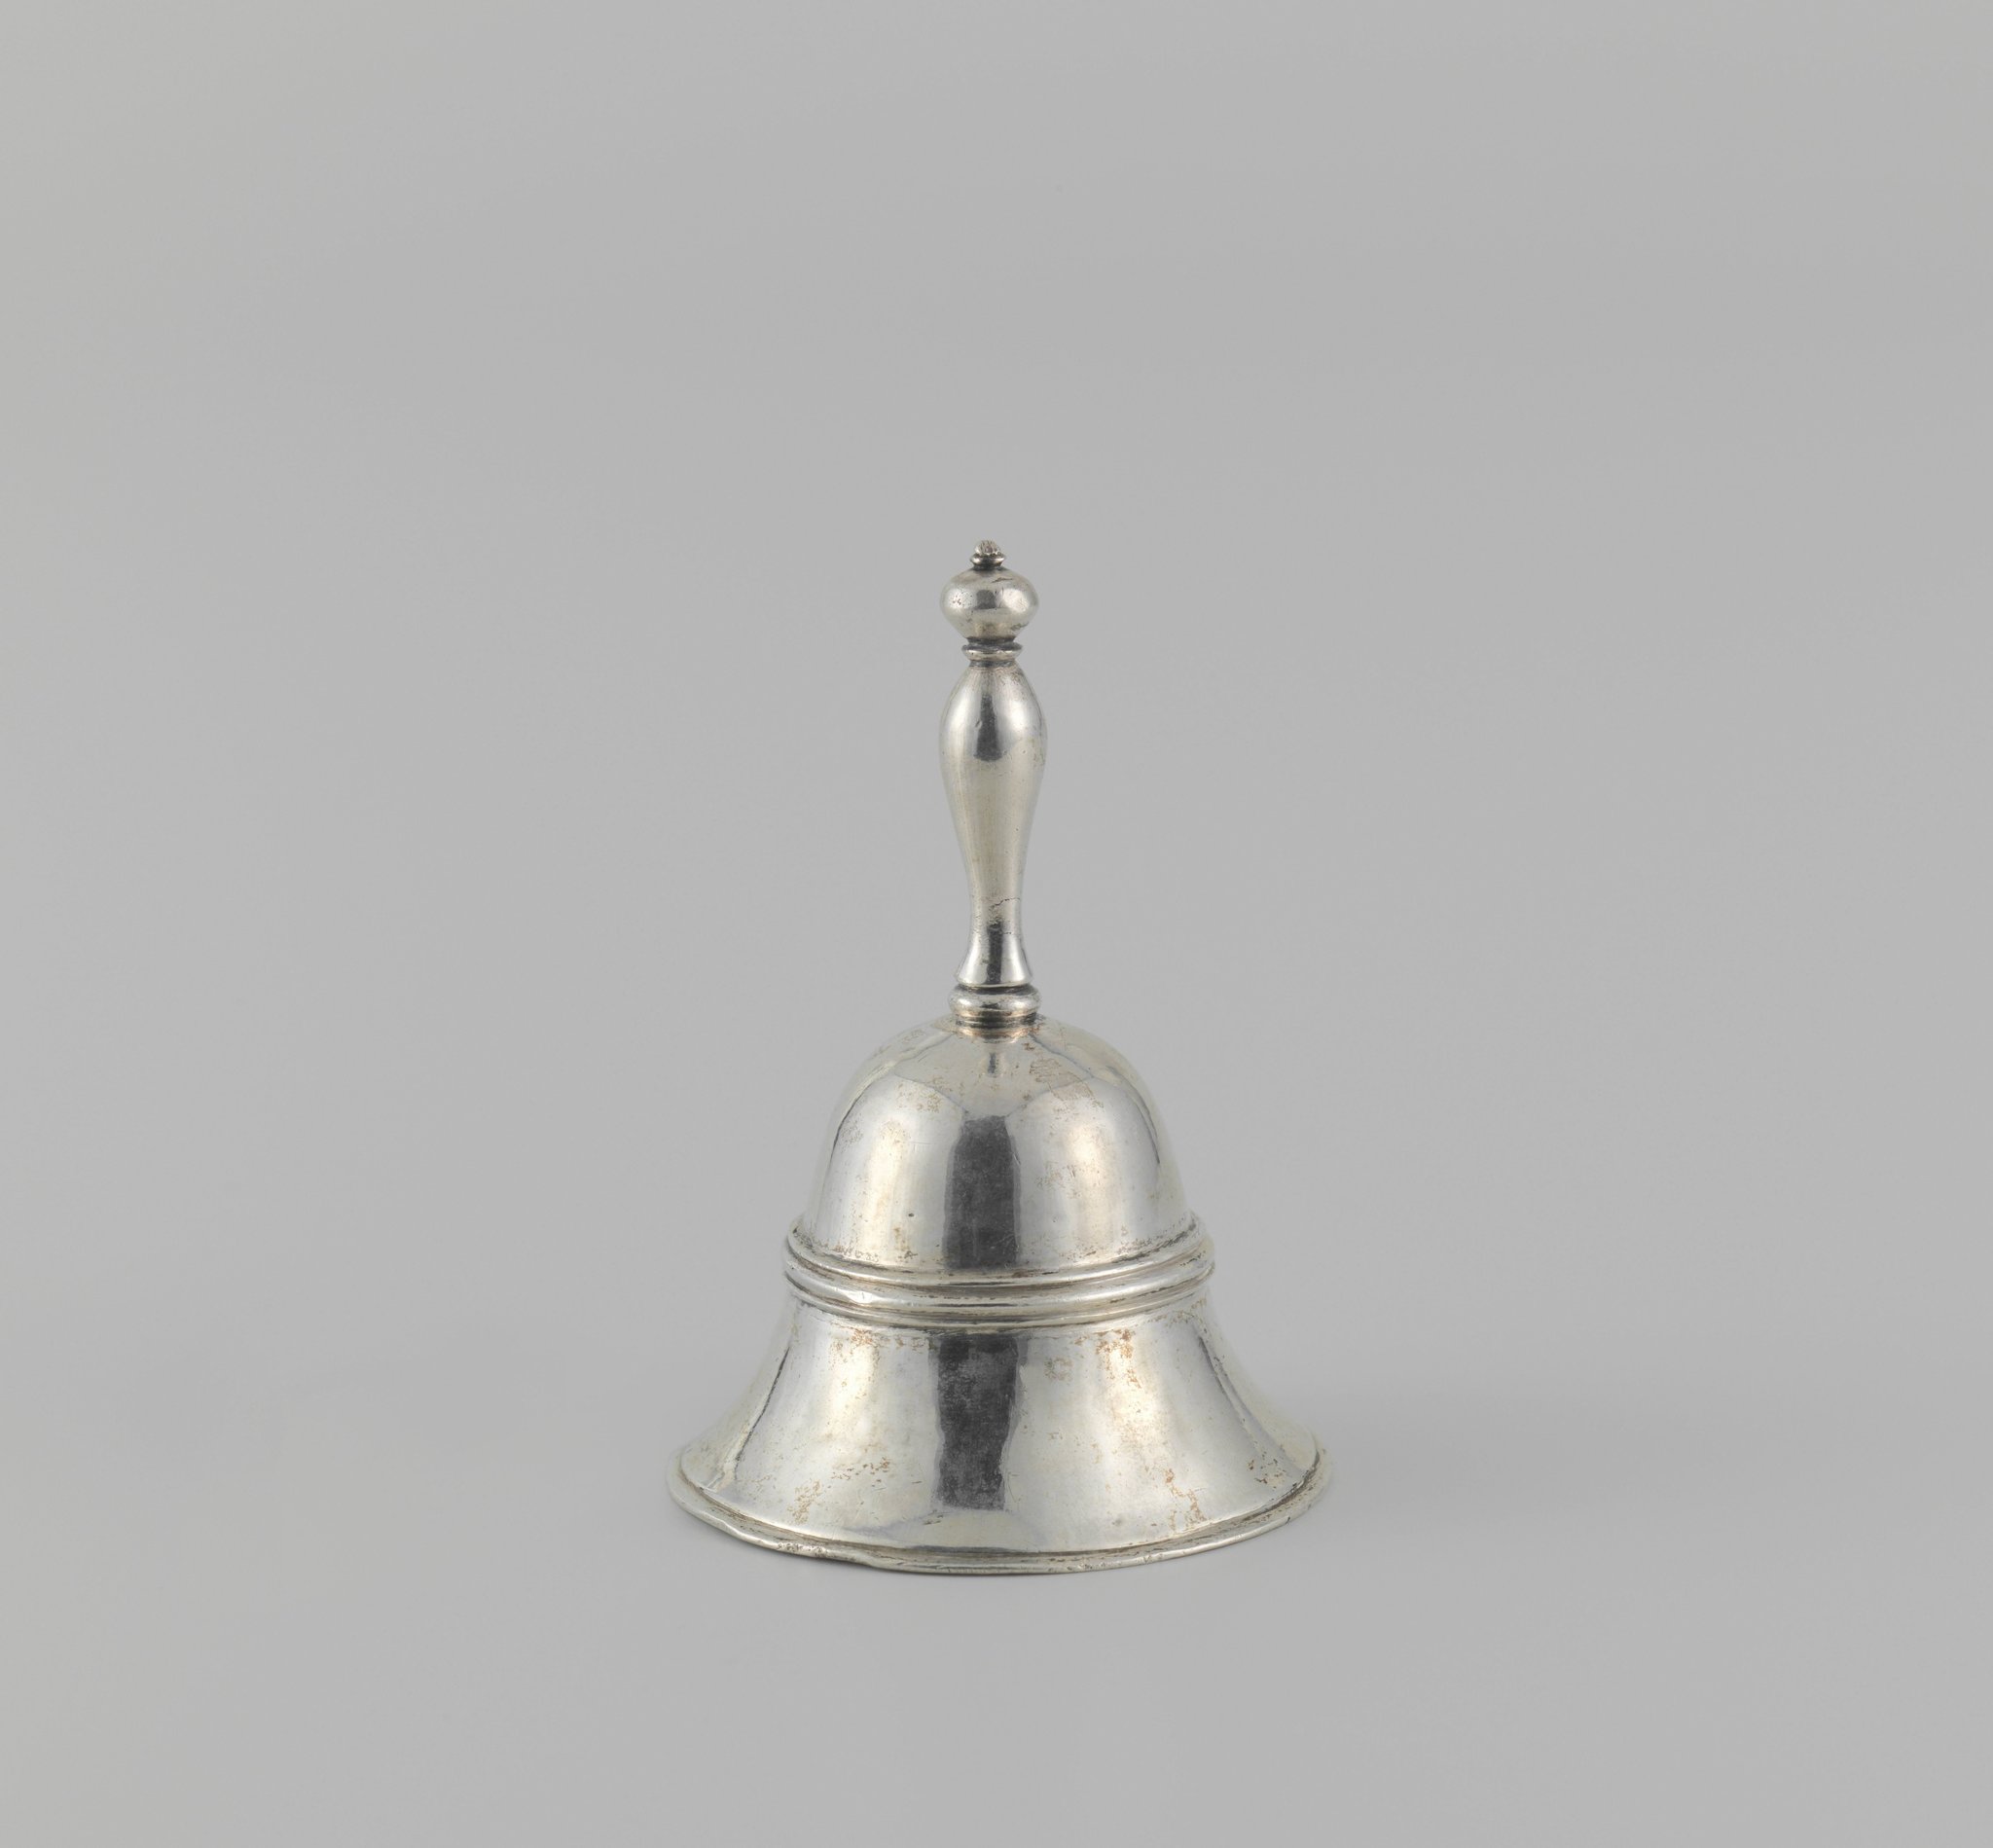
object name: percussion instrument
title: Handbell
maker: johannes van somerwil (i)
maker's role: silversmith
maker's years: 1715-1764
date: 1758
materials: silver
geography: amsterdam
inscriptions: maker's mark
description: Klokvormige tafelbel met handvat. Het handvat is balustervormig. Op de bel ligt halverwege een opgelegde bies. De tafelbel is gemerkt: stk.= Amsterdam, jrl.= Y (1758), mt.= toegeschreven aan Johannes van Somerwil (I).